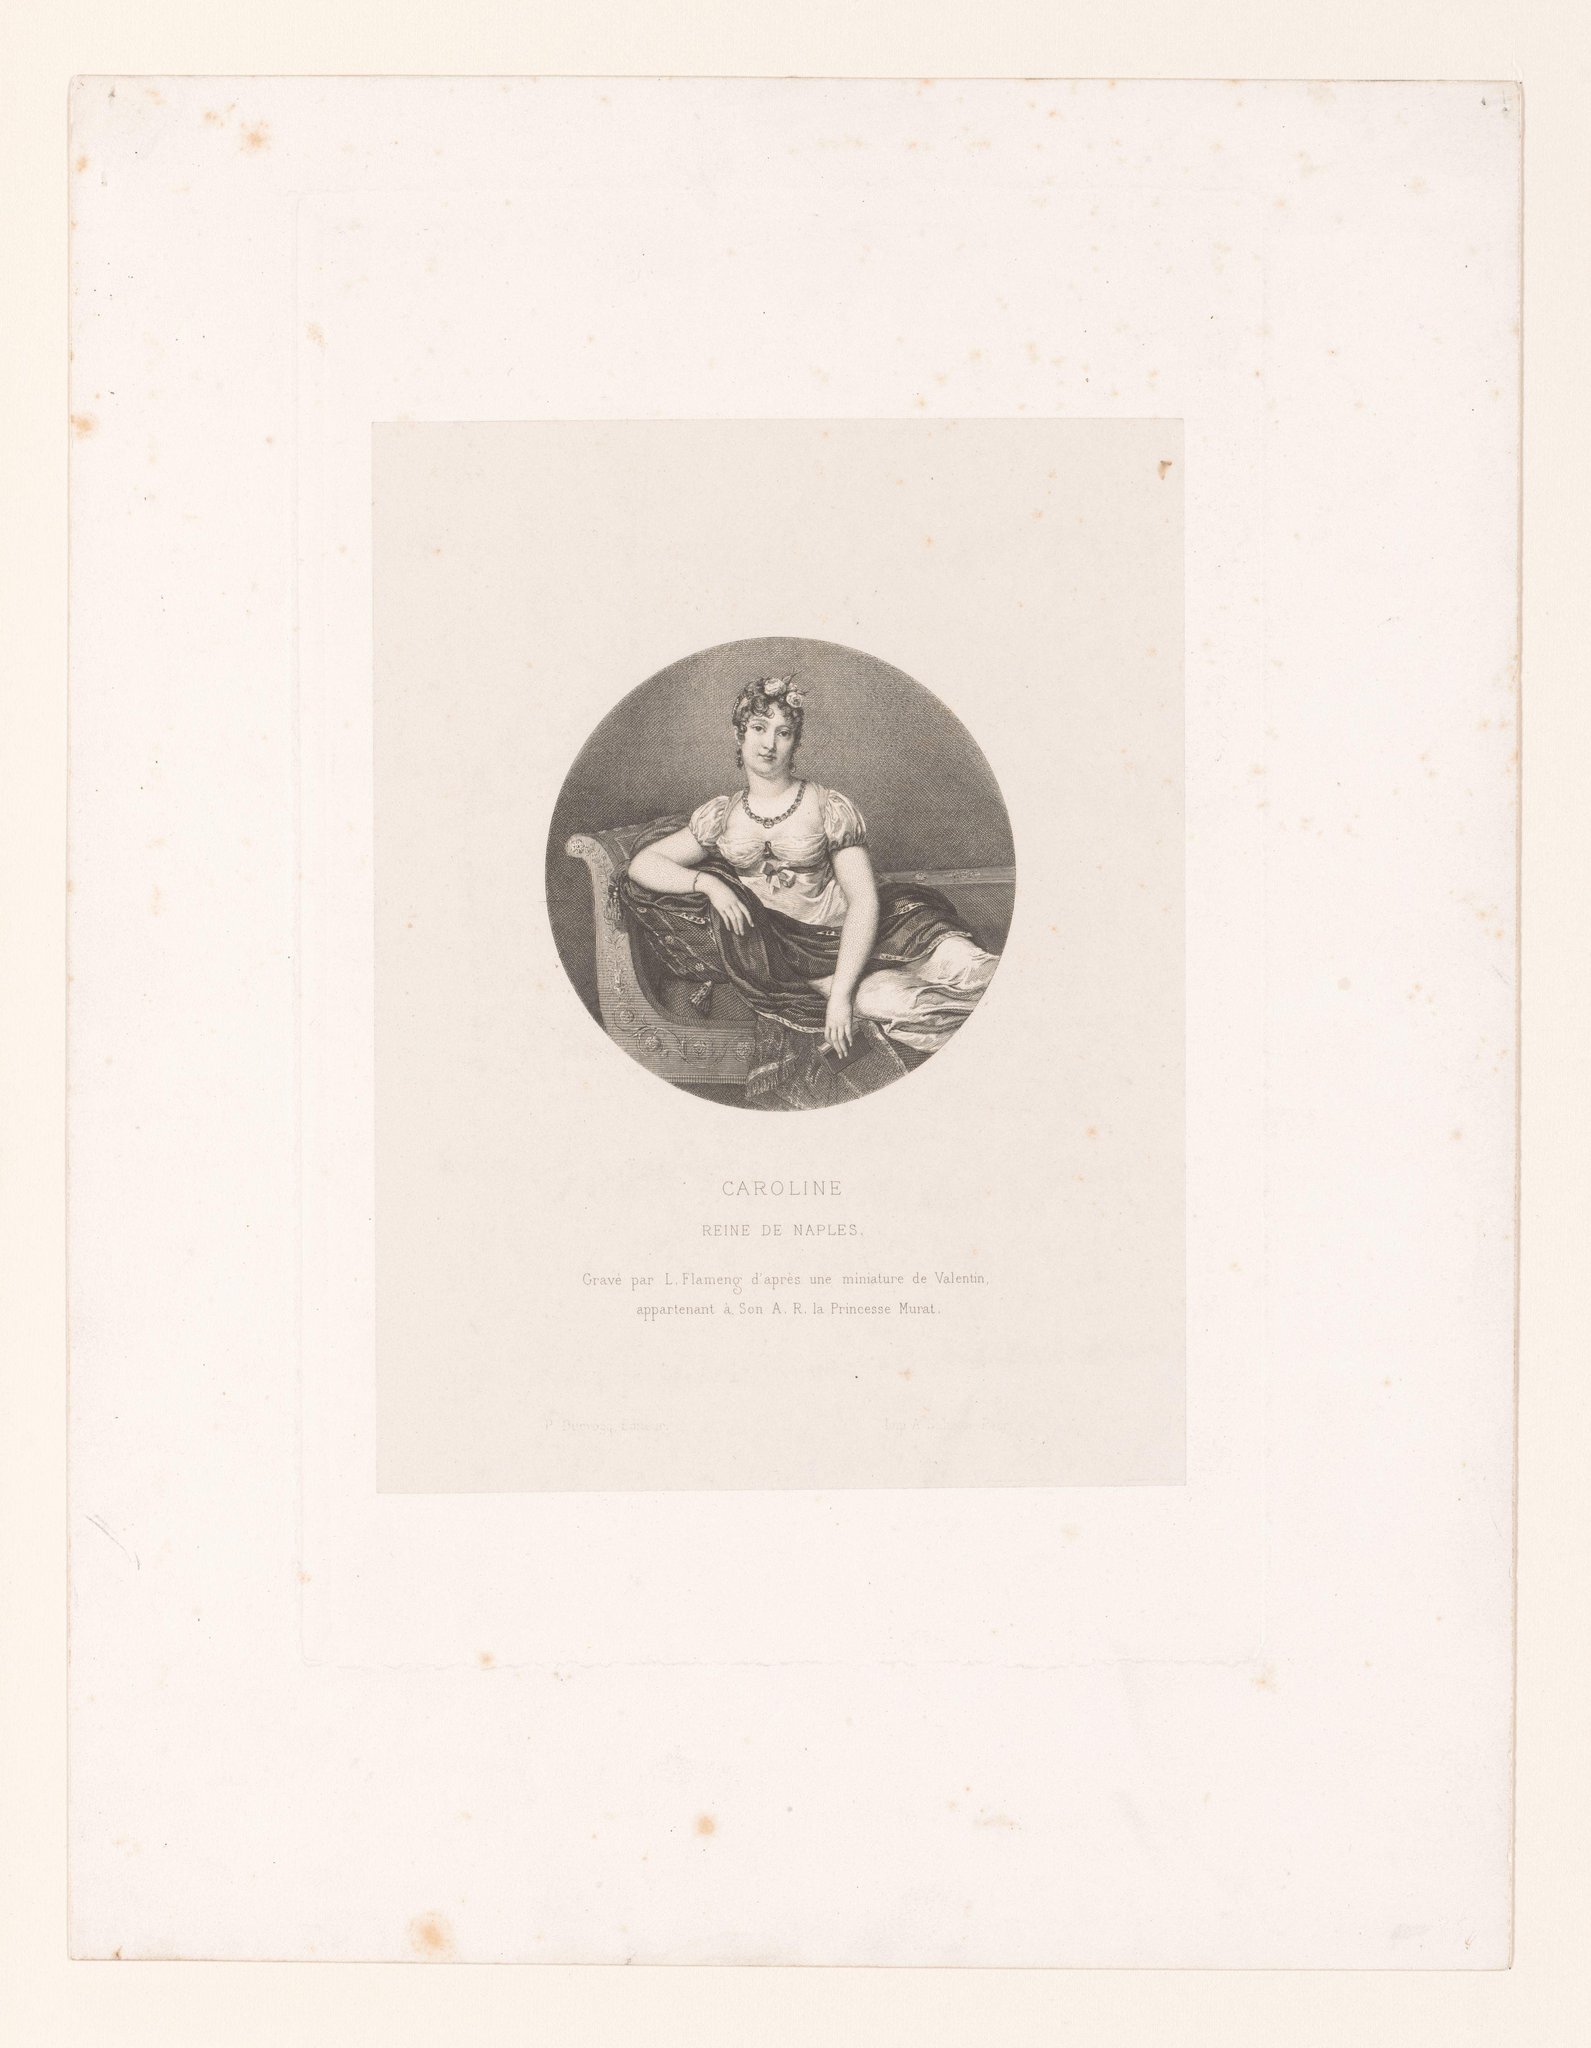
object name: print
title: Caroline reine de Naples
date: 1841-1910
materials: paper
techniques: engraving, etching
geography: paris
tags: historical persons - bb - woman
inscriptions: collector's mark: Lugt 2228